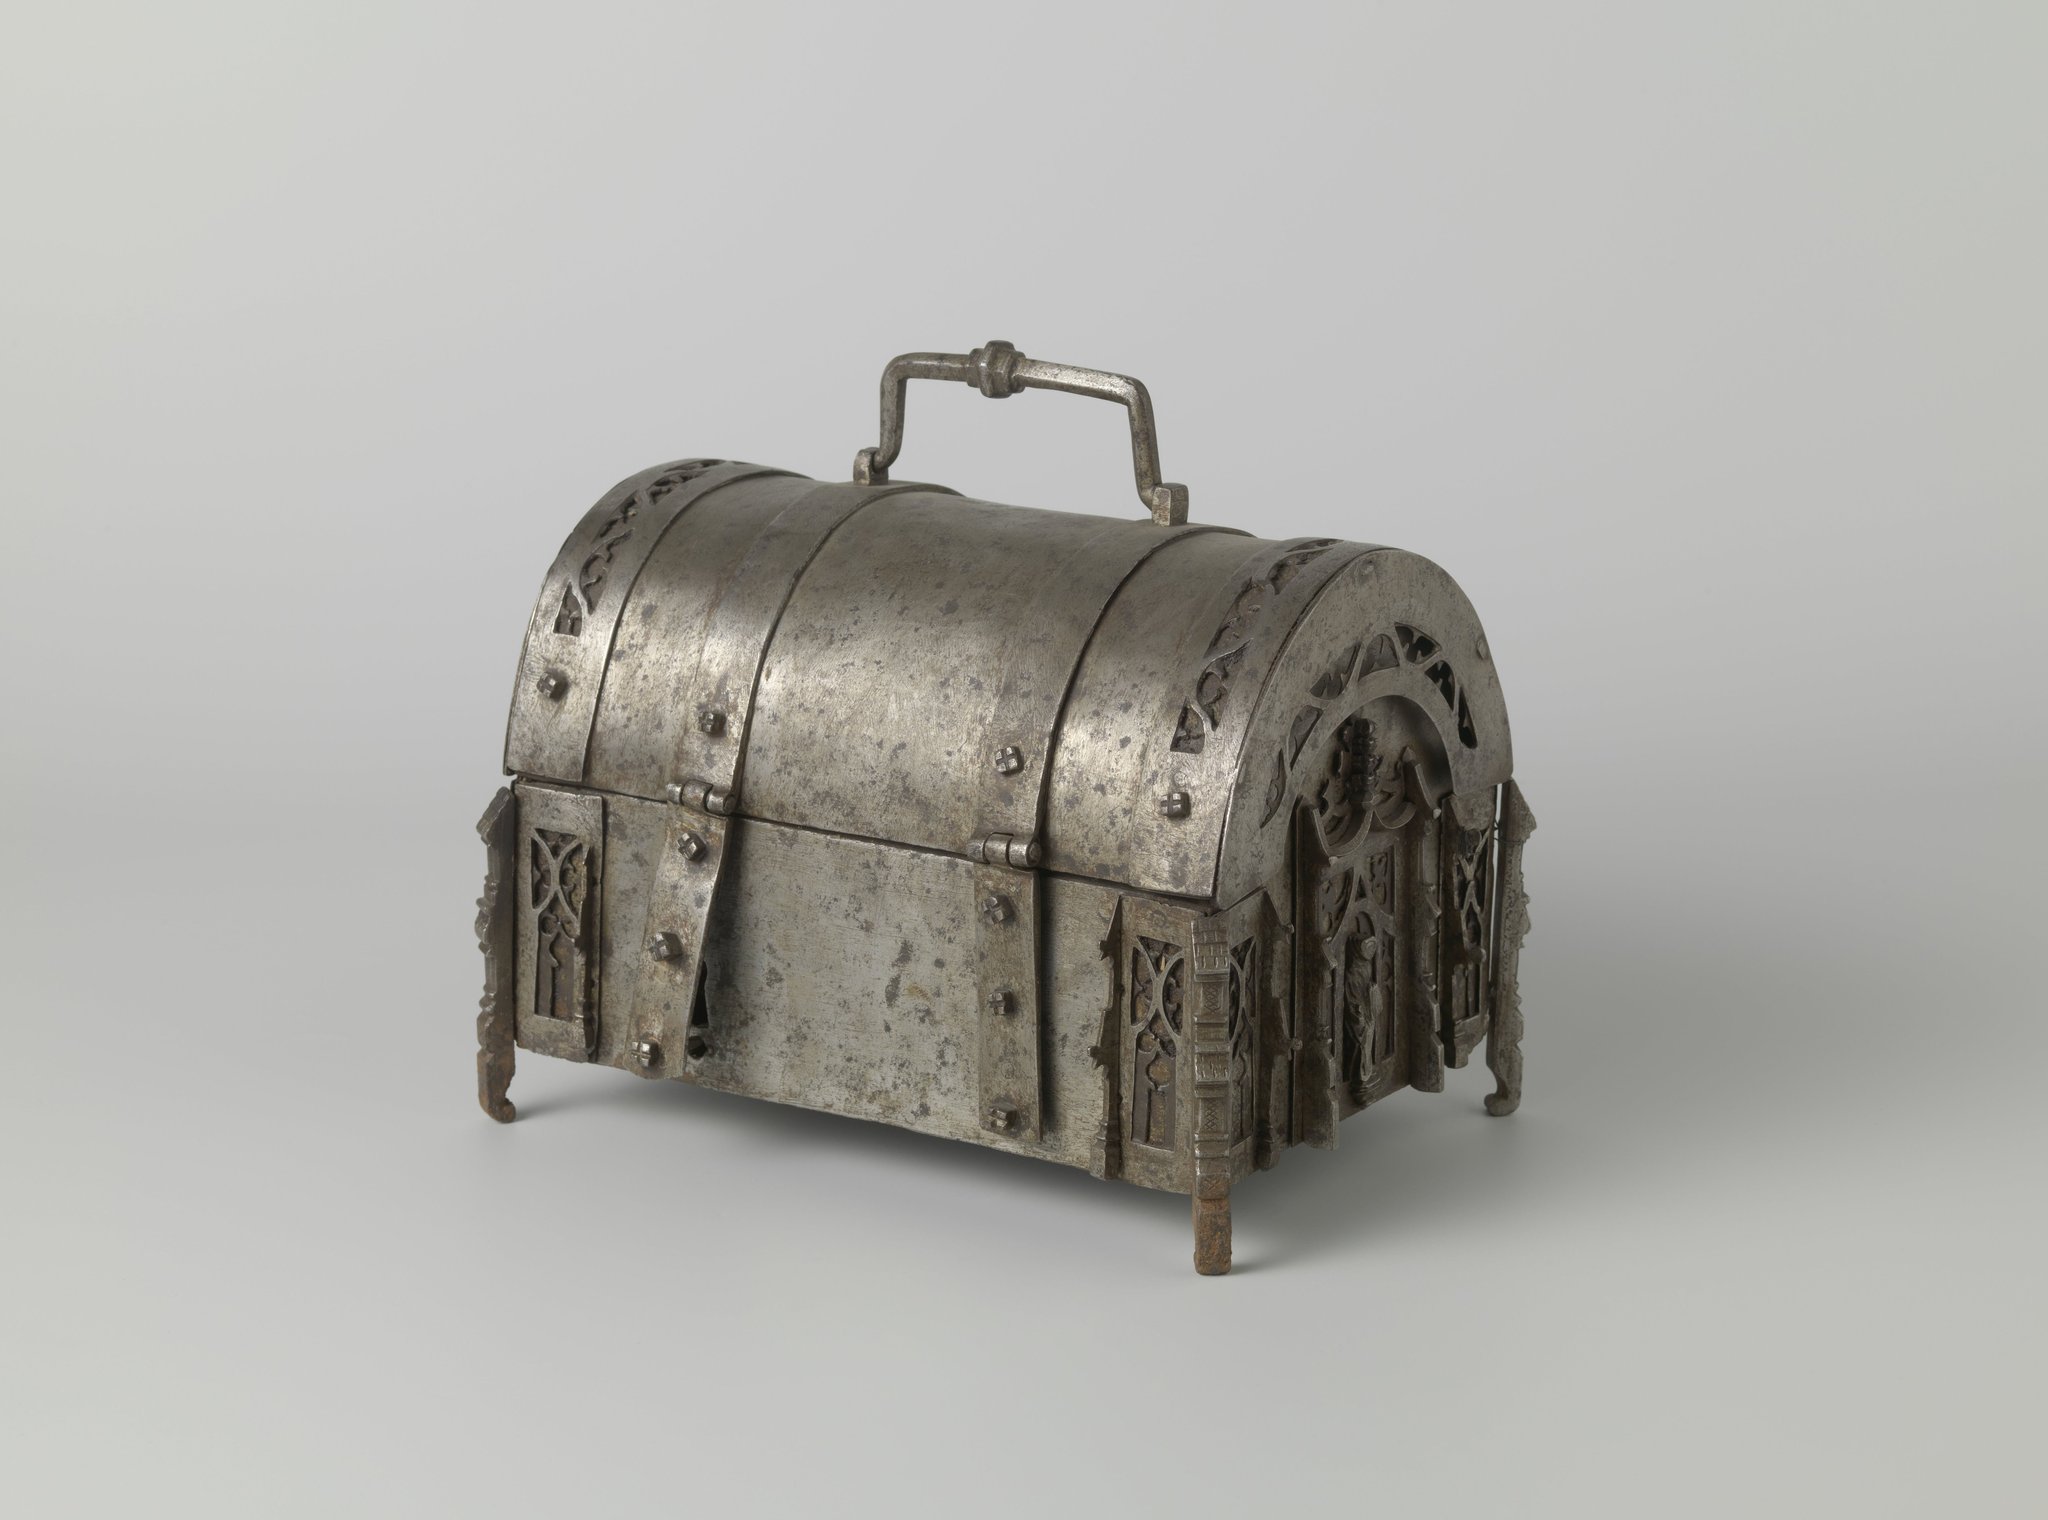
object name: jewel case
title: Juwelenkoffer van ijzer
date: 1400-1500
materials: iron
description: Een ijzeren juwelenkoffer op vier poten met hengsel, boogvormig deksel en verborgen slot, en uitgeslagen versieringen, waaronder een bisschopsbeeld.